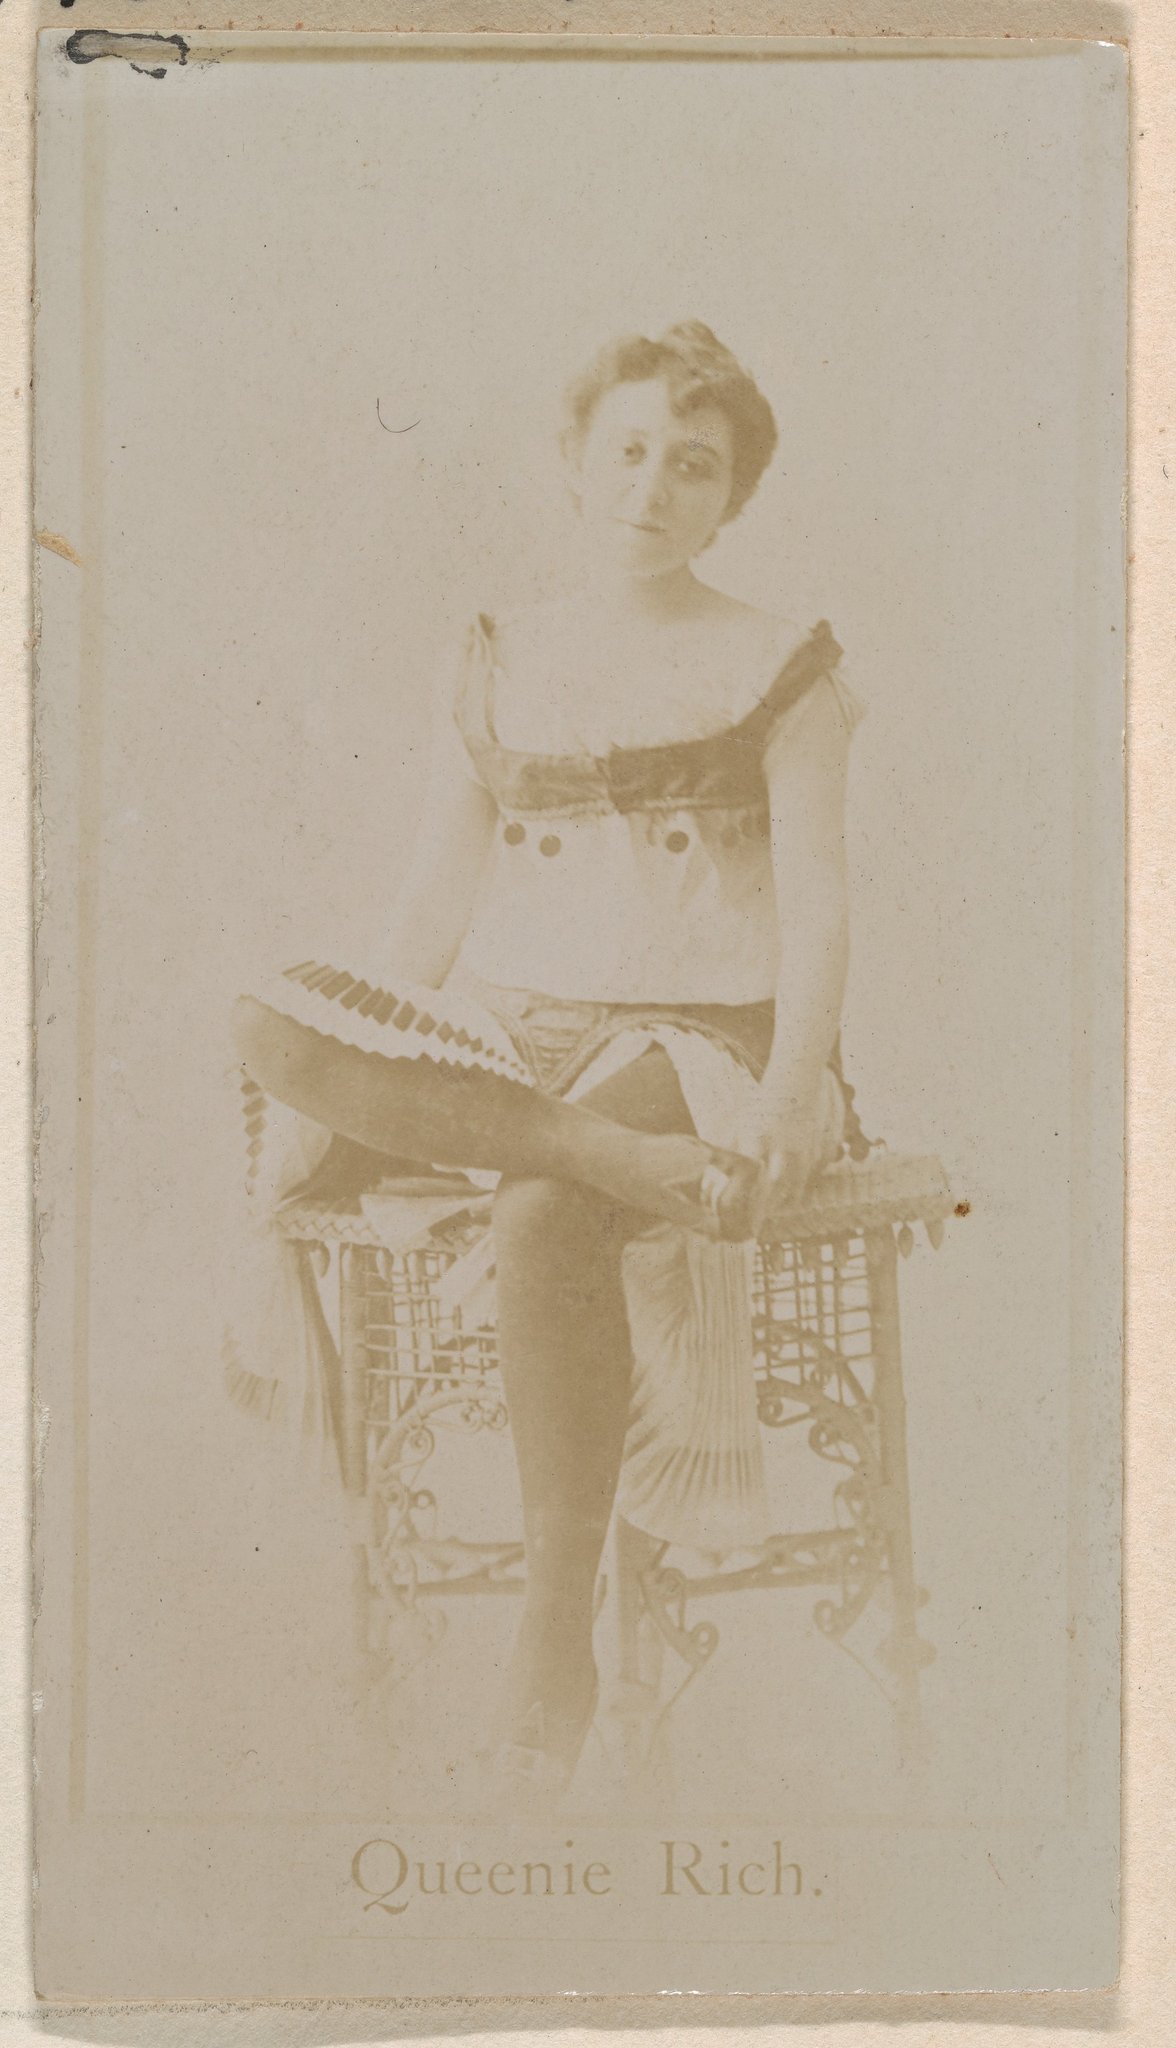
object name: photograph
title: Queenie Rich, from the Actresses series (N245) issued by Kinney Brothers to promote Sweet Caporal Cigarettes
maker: kinney brothers tobacco company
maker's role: publisher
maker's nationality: american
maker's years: 1869-2011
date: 1890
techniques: albumen silver print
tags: portraits,women,actresses